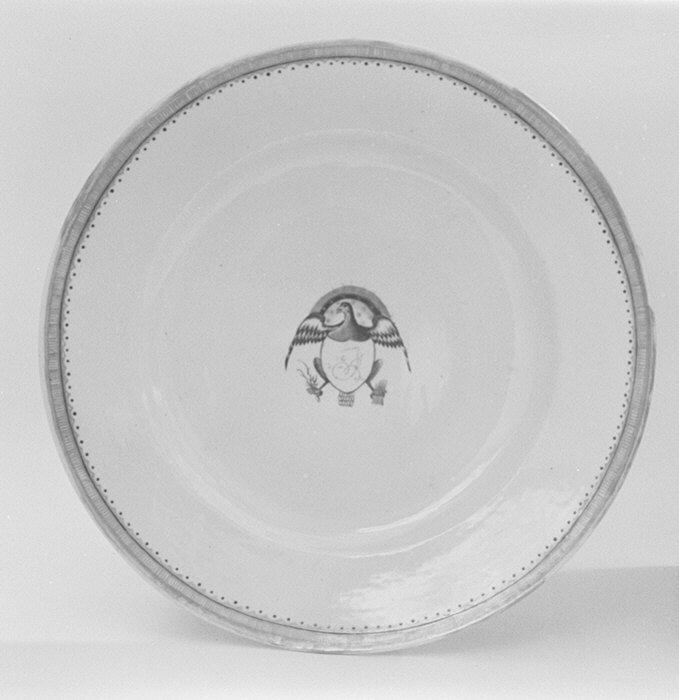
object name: plate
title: Plate (part of a service)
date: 1767-1833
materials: hard paste porcelain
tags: eagles,coat of arms